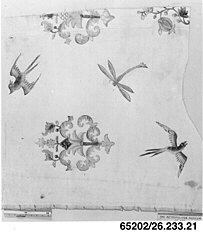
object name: fragment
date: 1774-1792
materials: silk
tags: birds,dragonflies